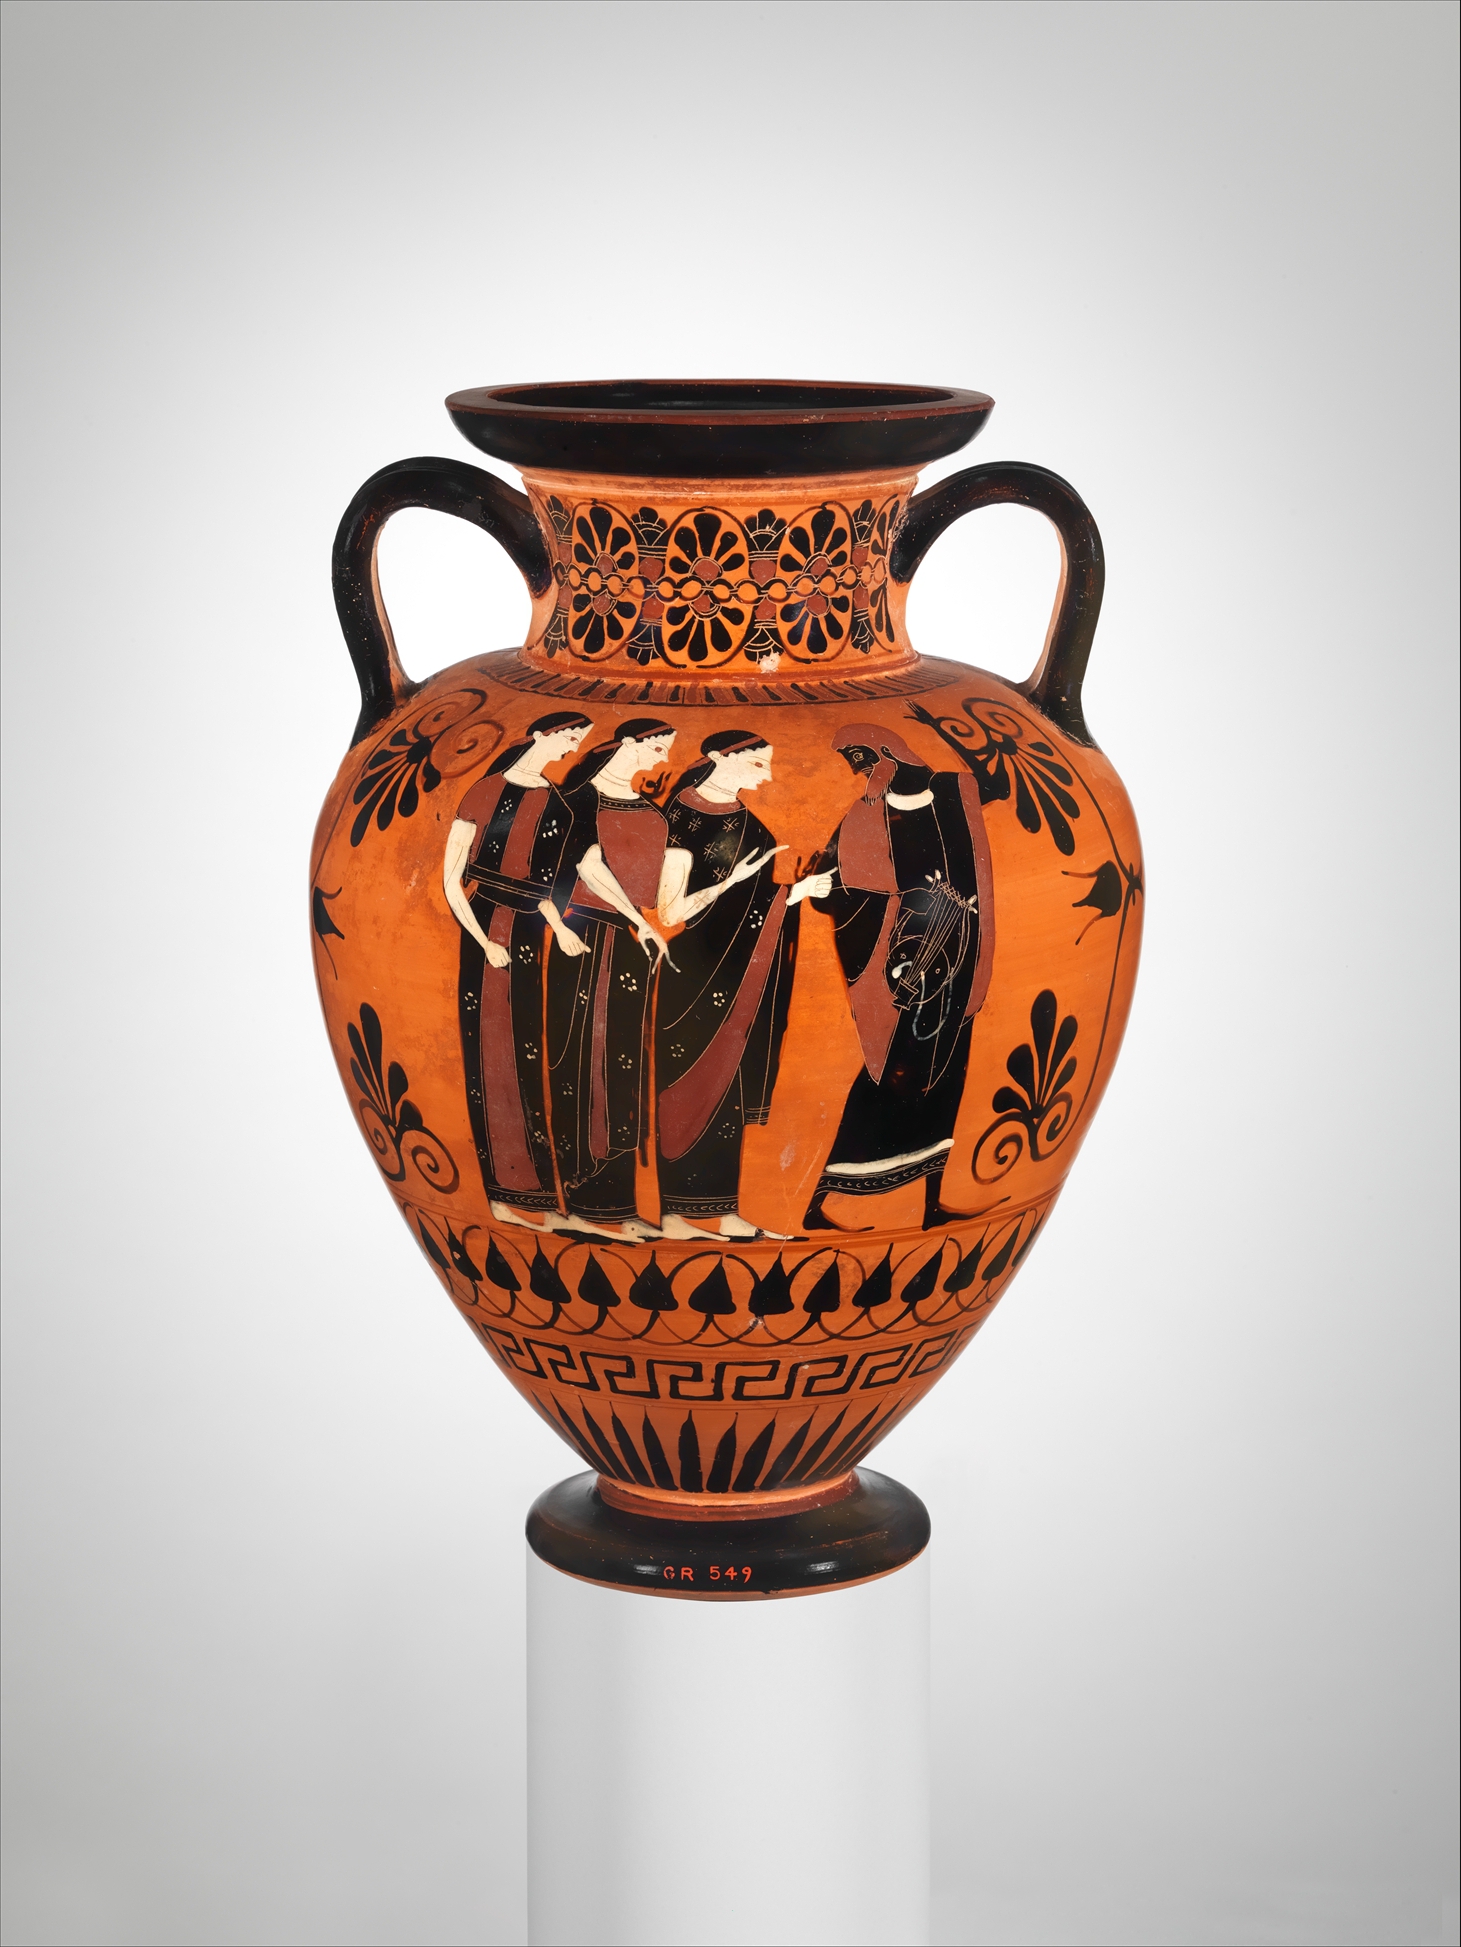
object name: neck amphora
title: Terracotta neck-amphora (jar)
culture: greek, attic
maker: swing painter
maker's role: artist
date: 540-530 BCE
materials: terracotta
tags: women,poseidon